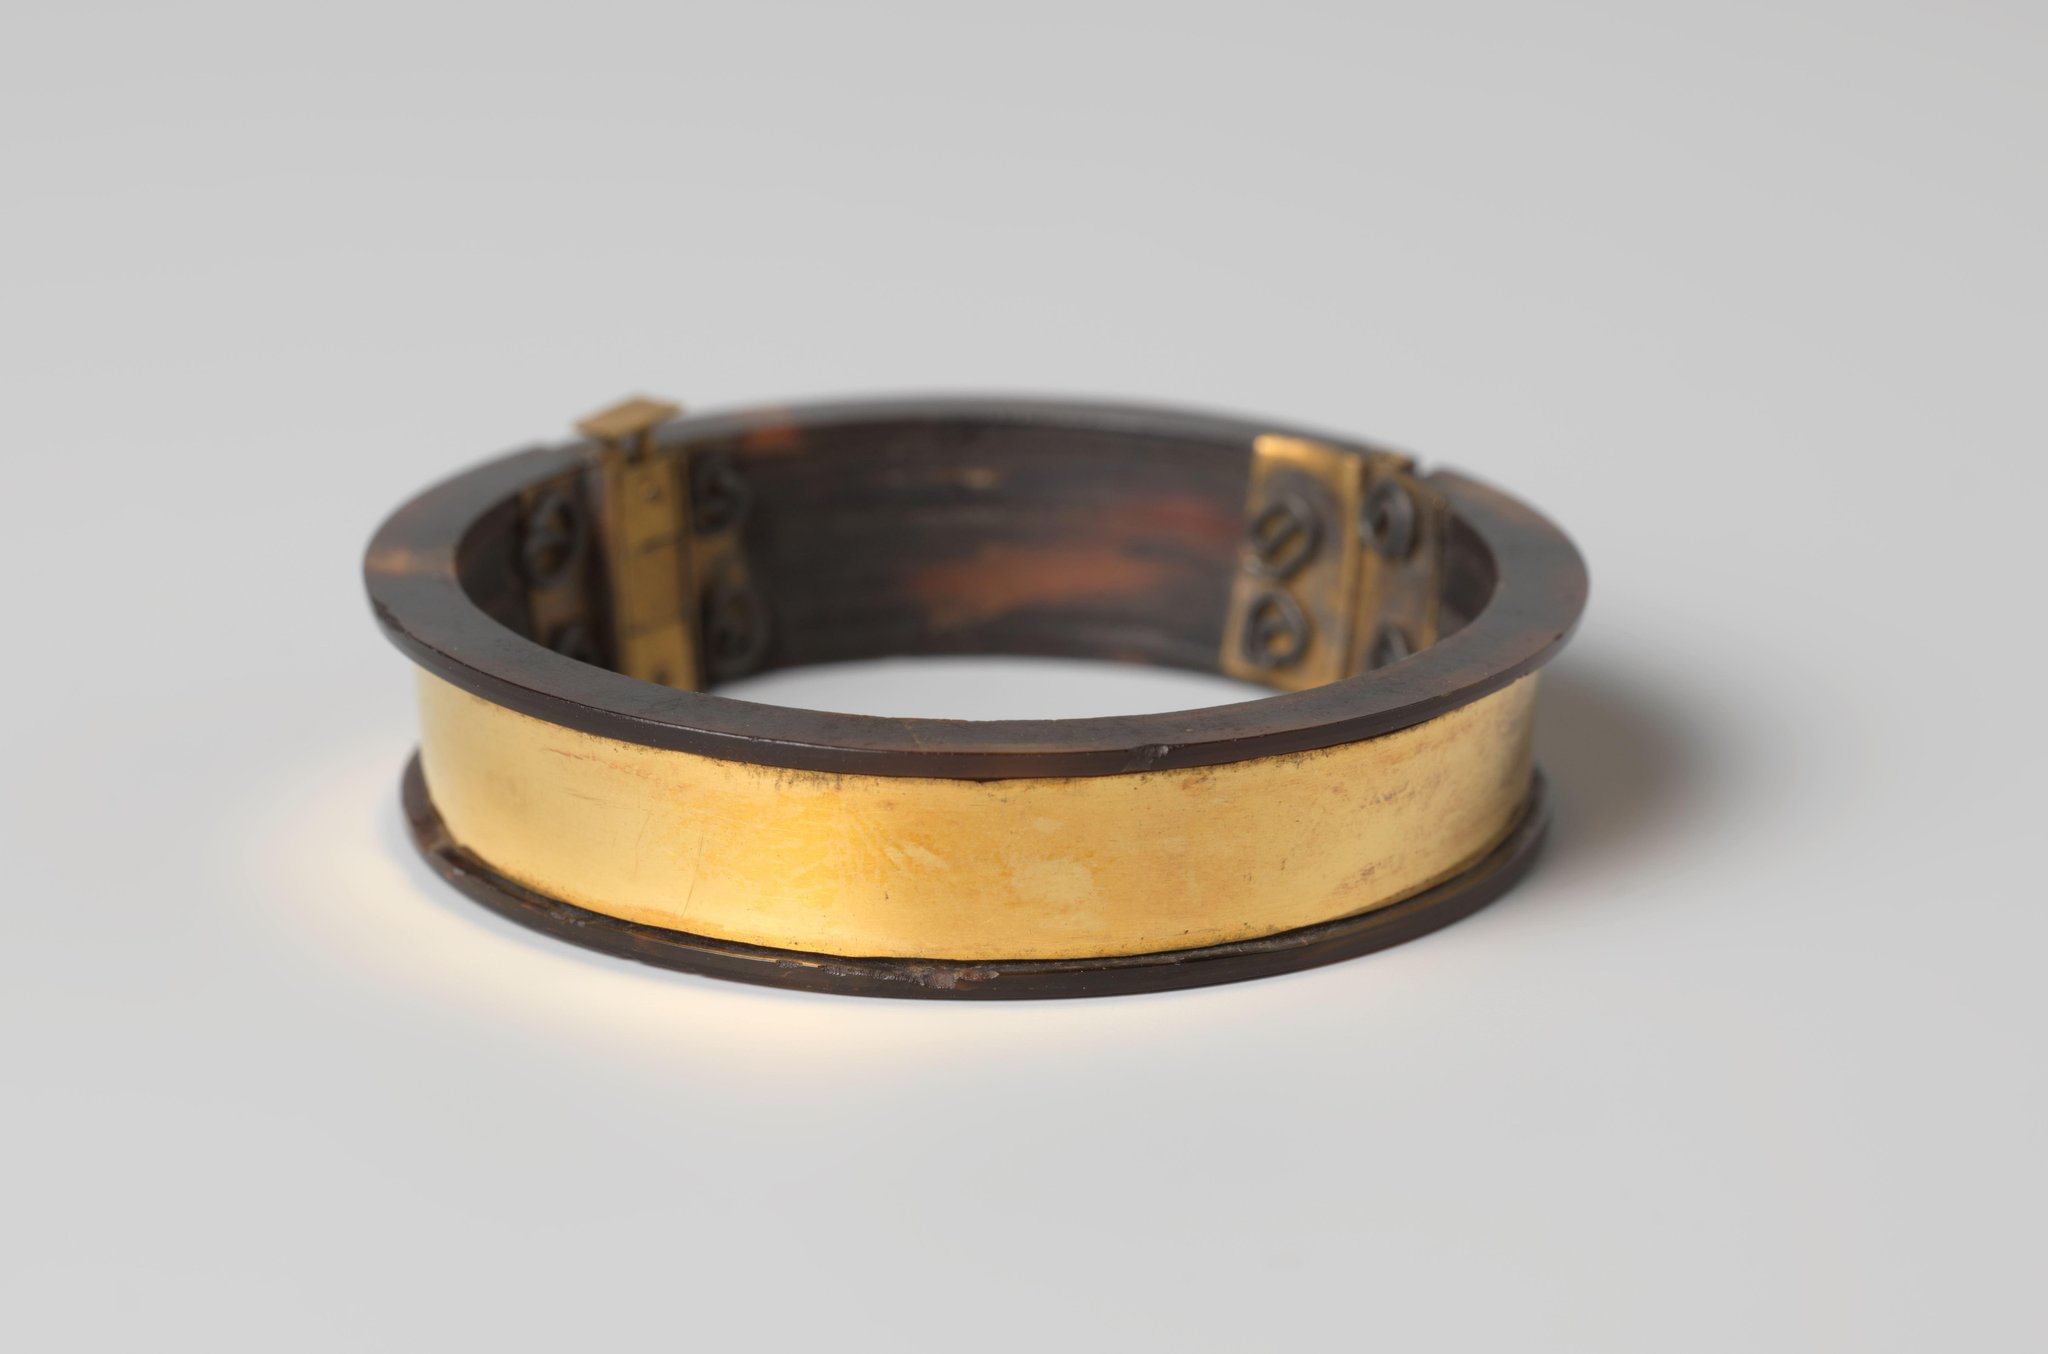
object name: churi jhabbedâr, churi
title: Pair of bracelets (churi)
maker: Anonymous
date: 1750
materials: gold, shell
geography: surat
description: Armband (churi) bestaande uit een uit schildpad gesneden ring met een scharnier en een gouden slot. Omsloten door een eenvoudig gouden bandbeslag. Vormt een paar met AK-NM-7053-A.